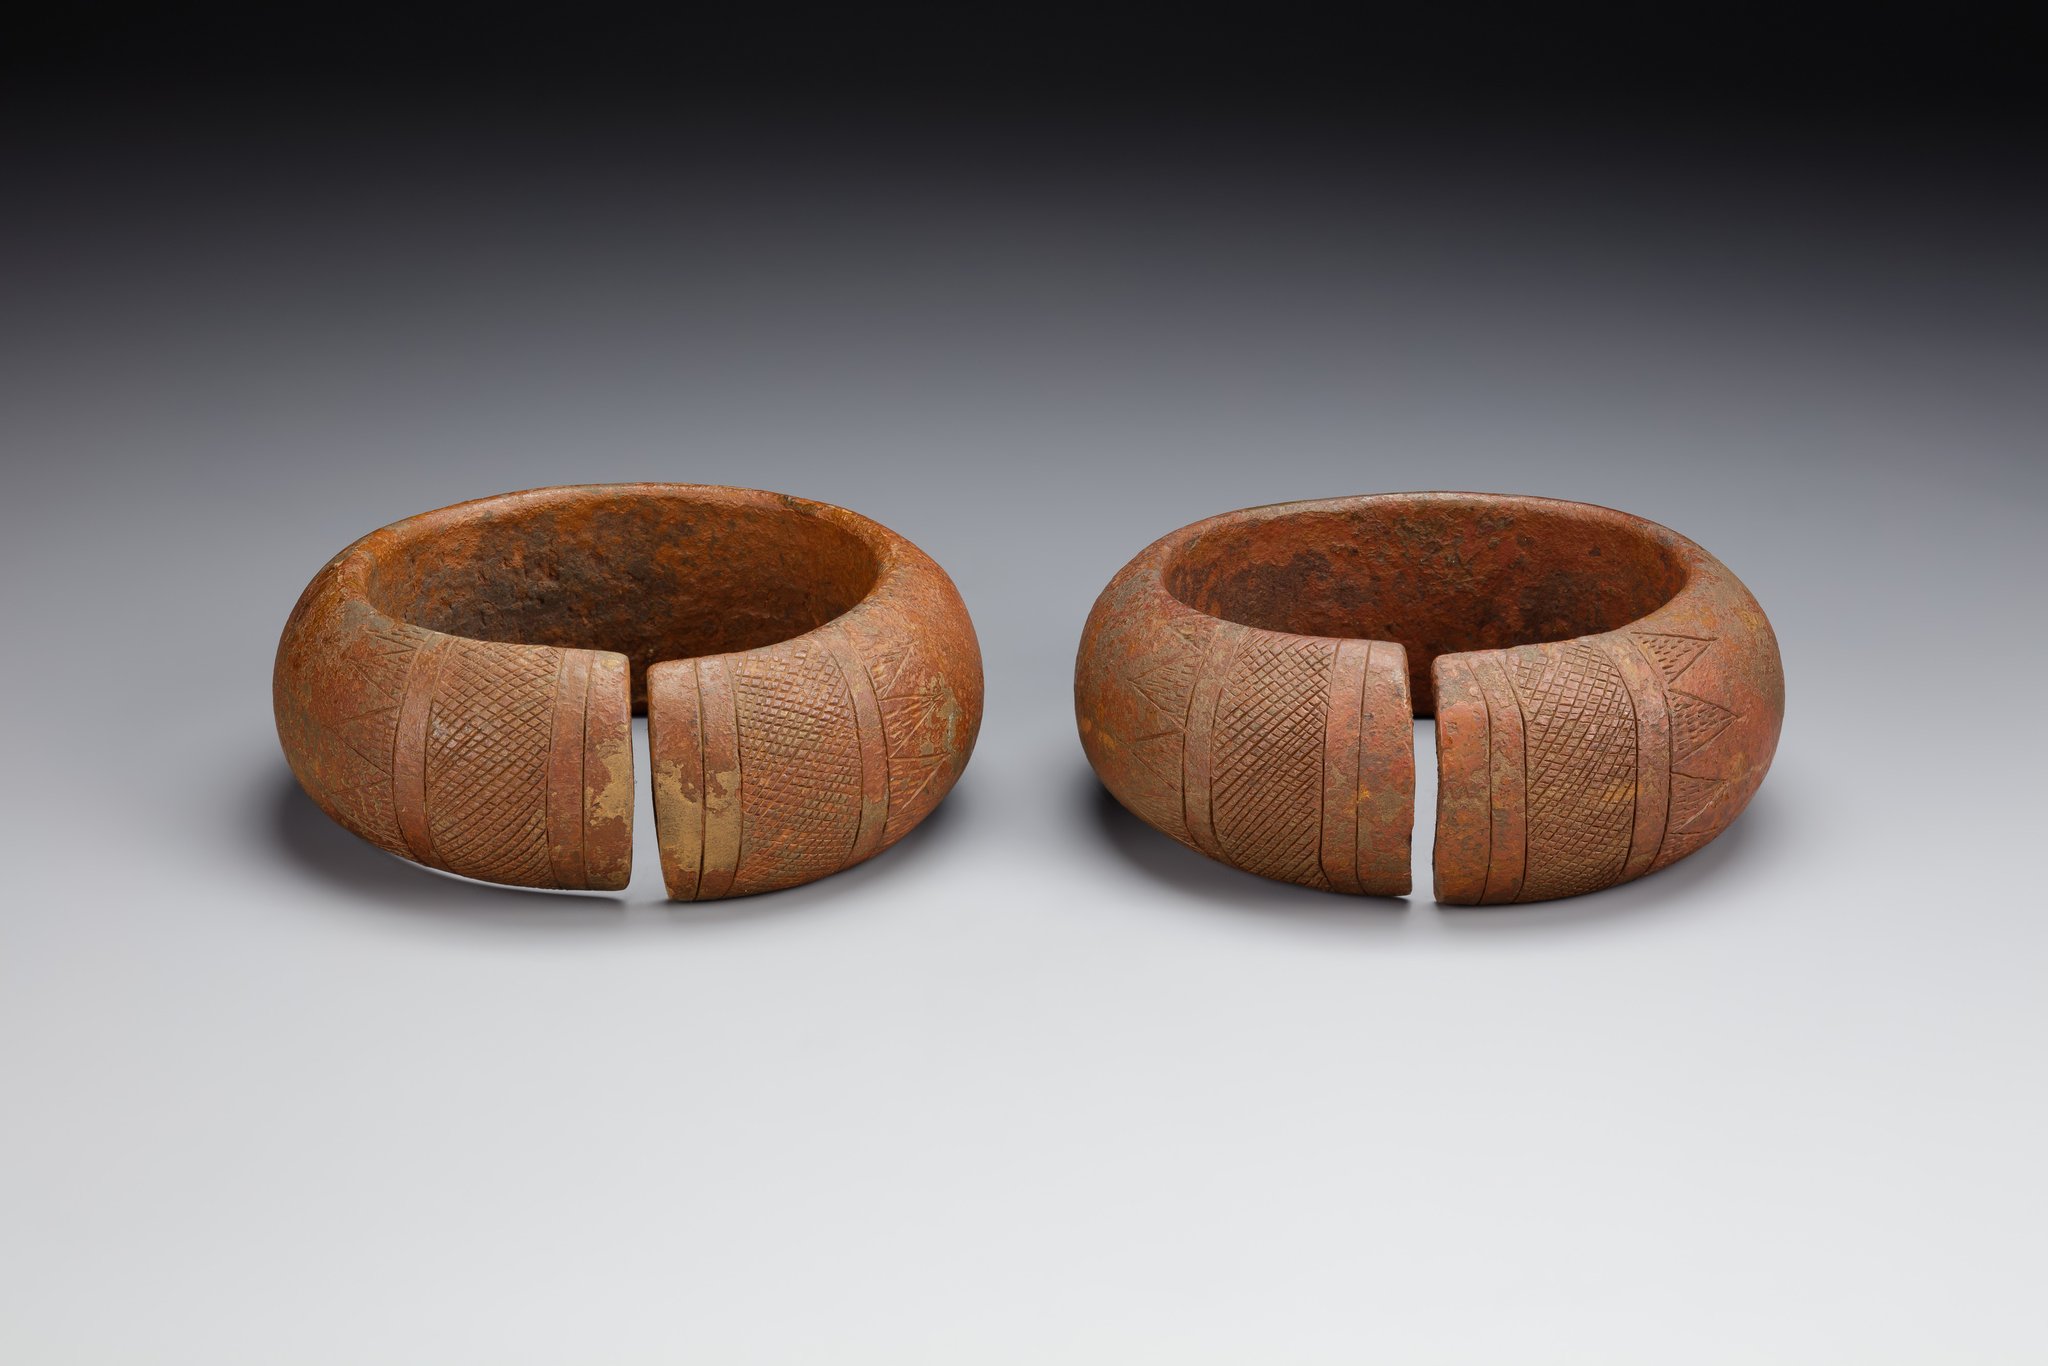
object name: anklet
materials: bronze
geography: nubia